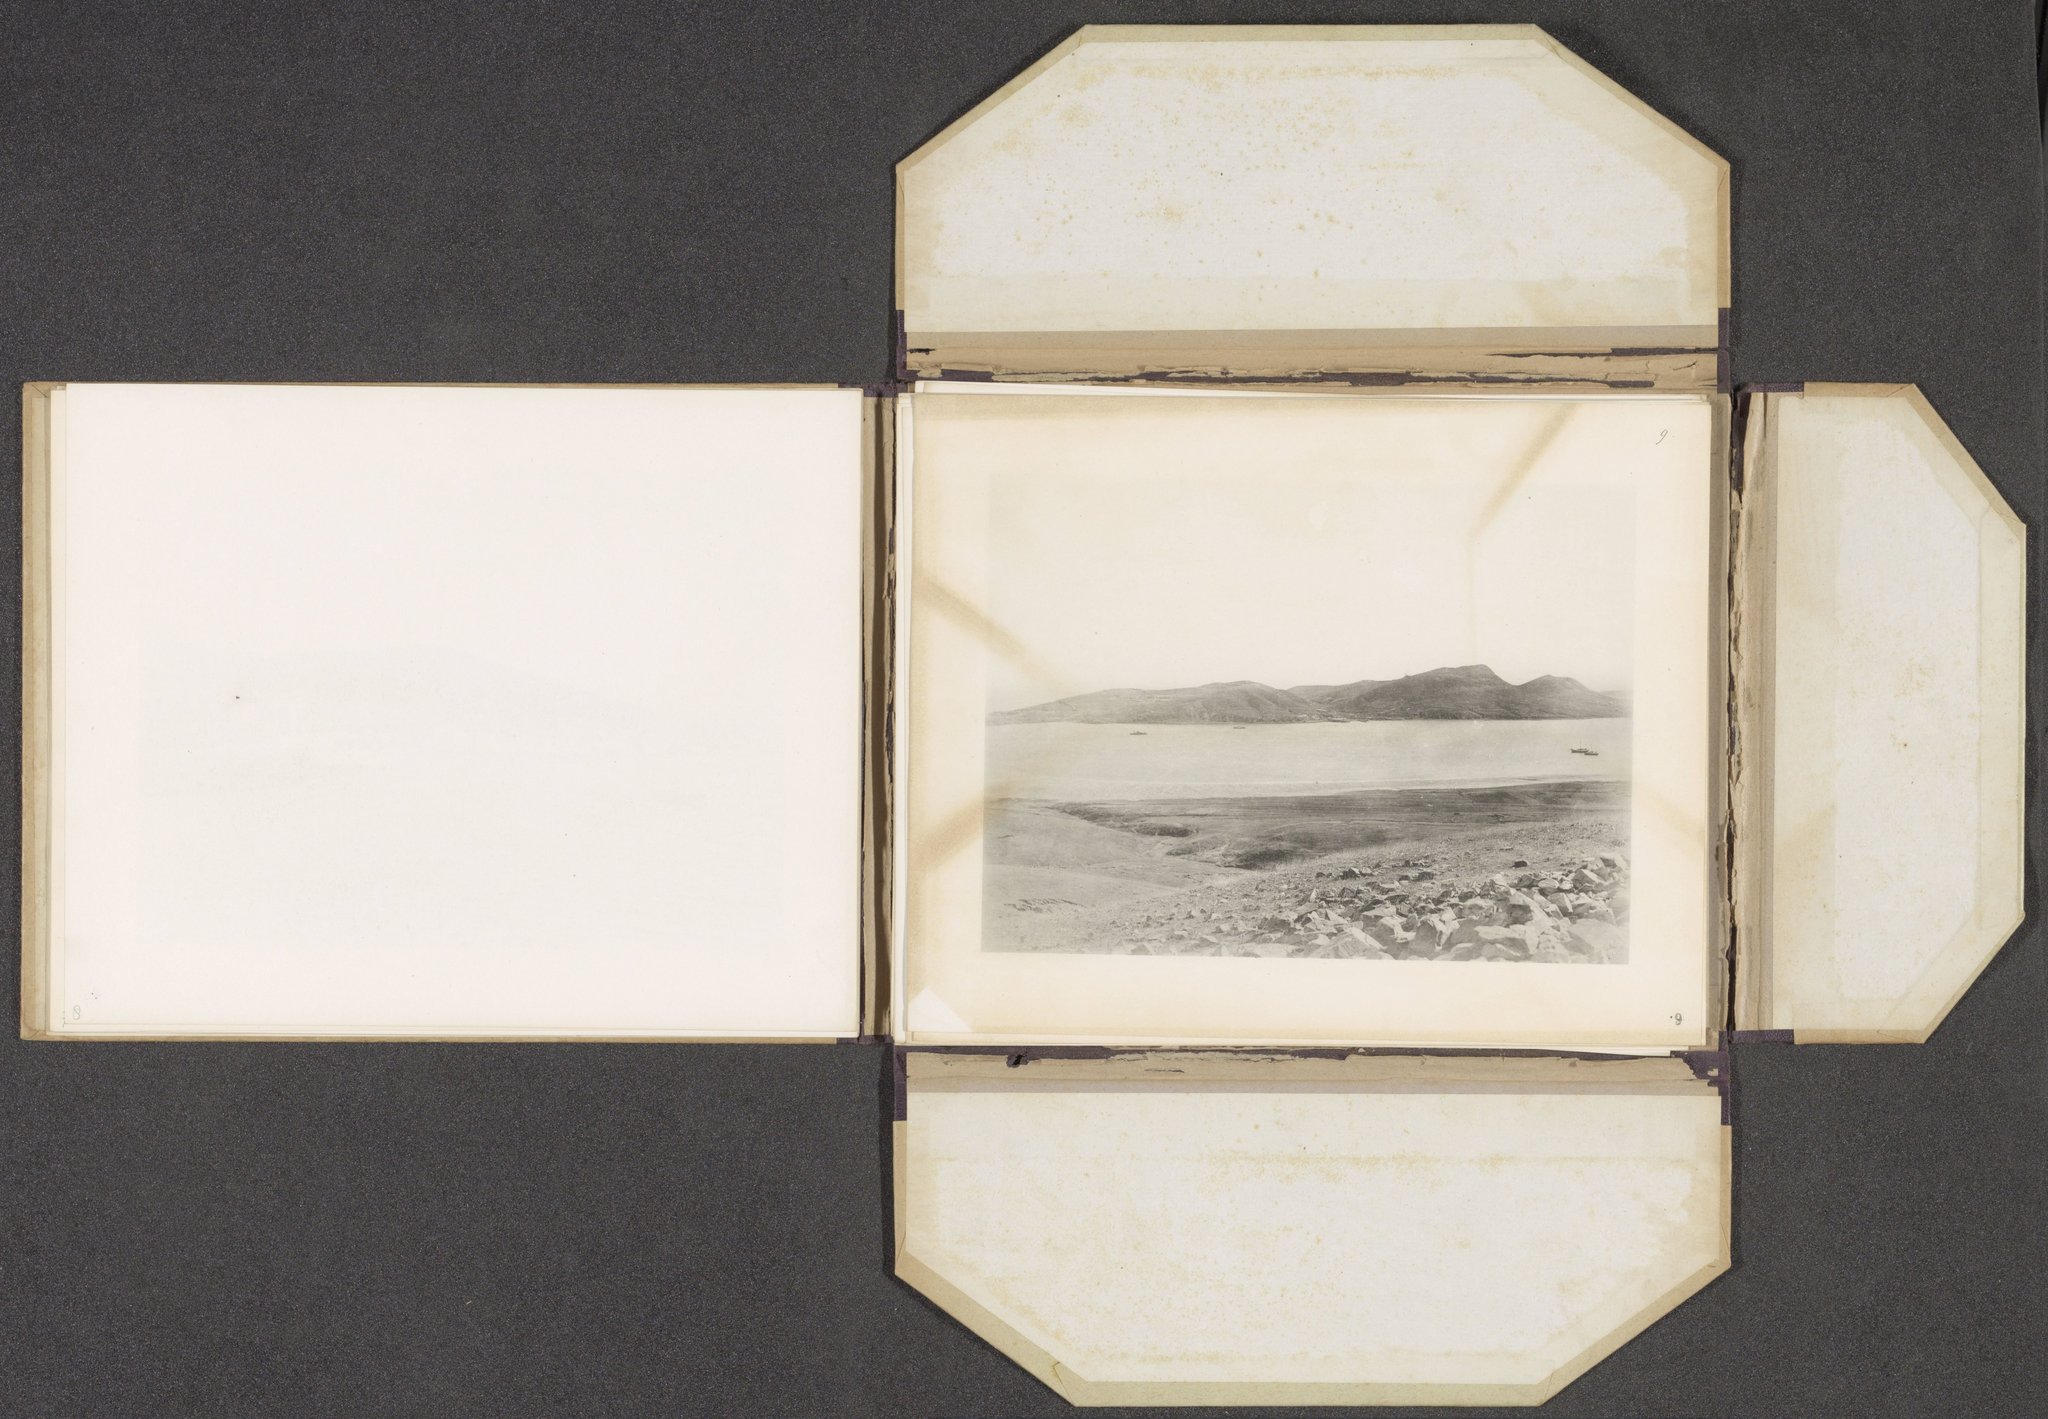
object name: photomechanical print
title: Gezicht op de baai bij Port Arthur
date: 1898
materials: paper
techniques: photograph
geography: manchuria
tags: gulf, bay, sea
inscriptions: number: ‘9’